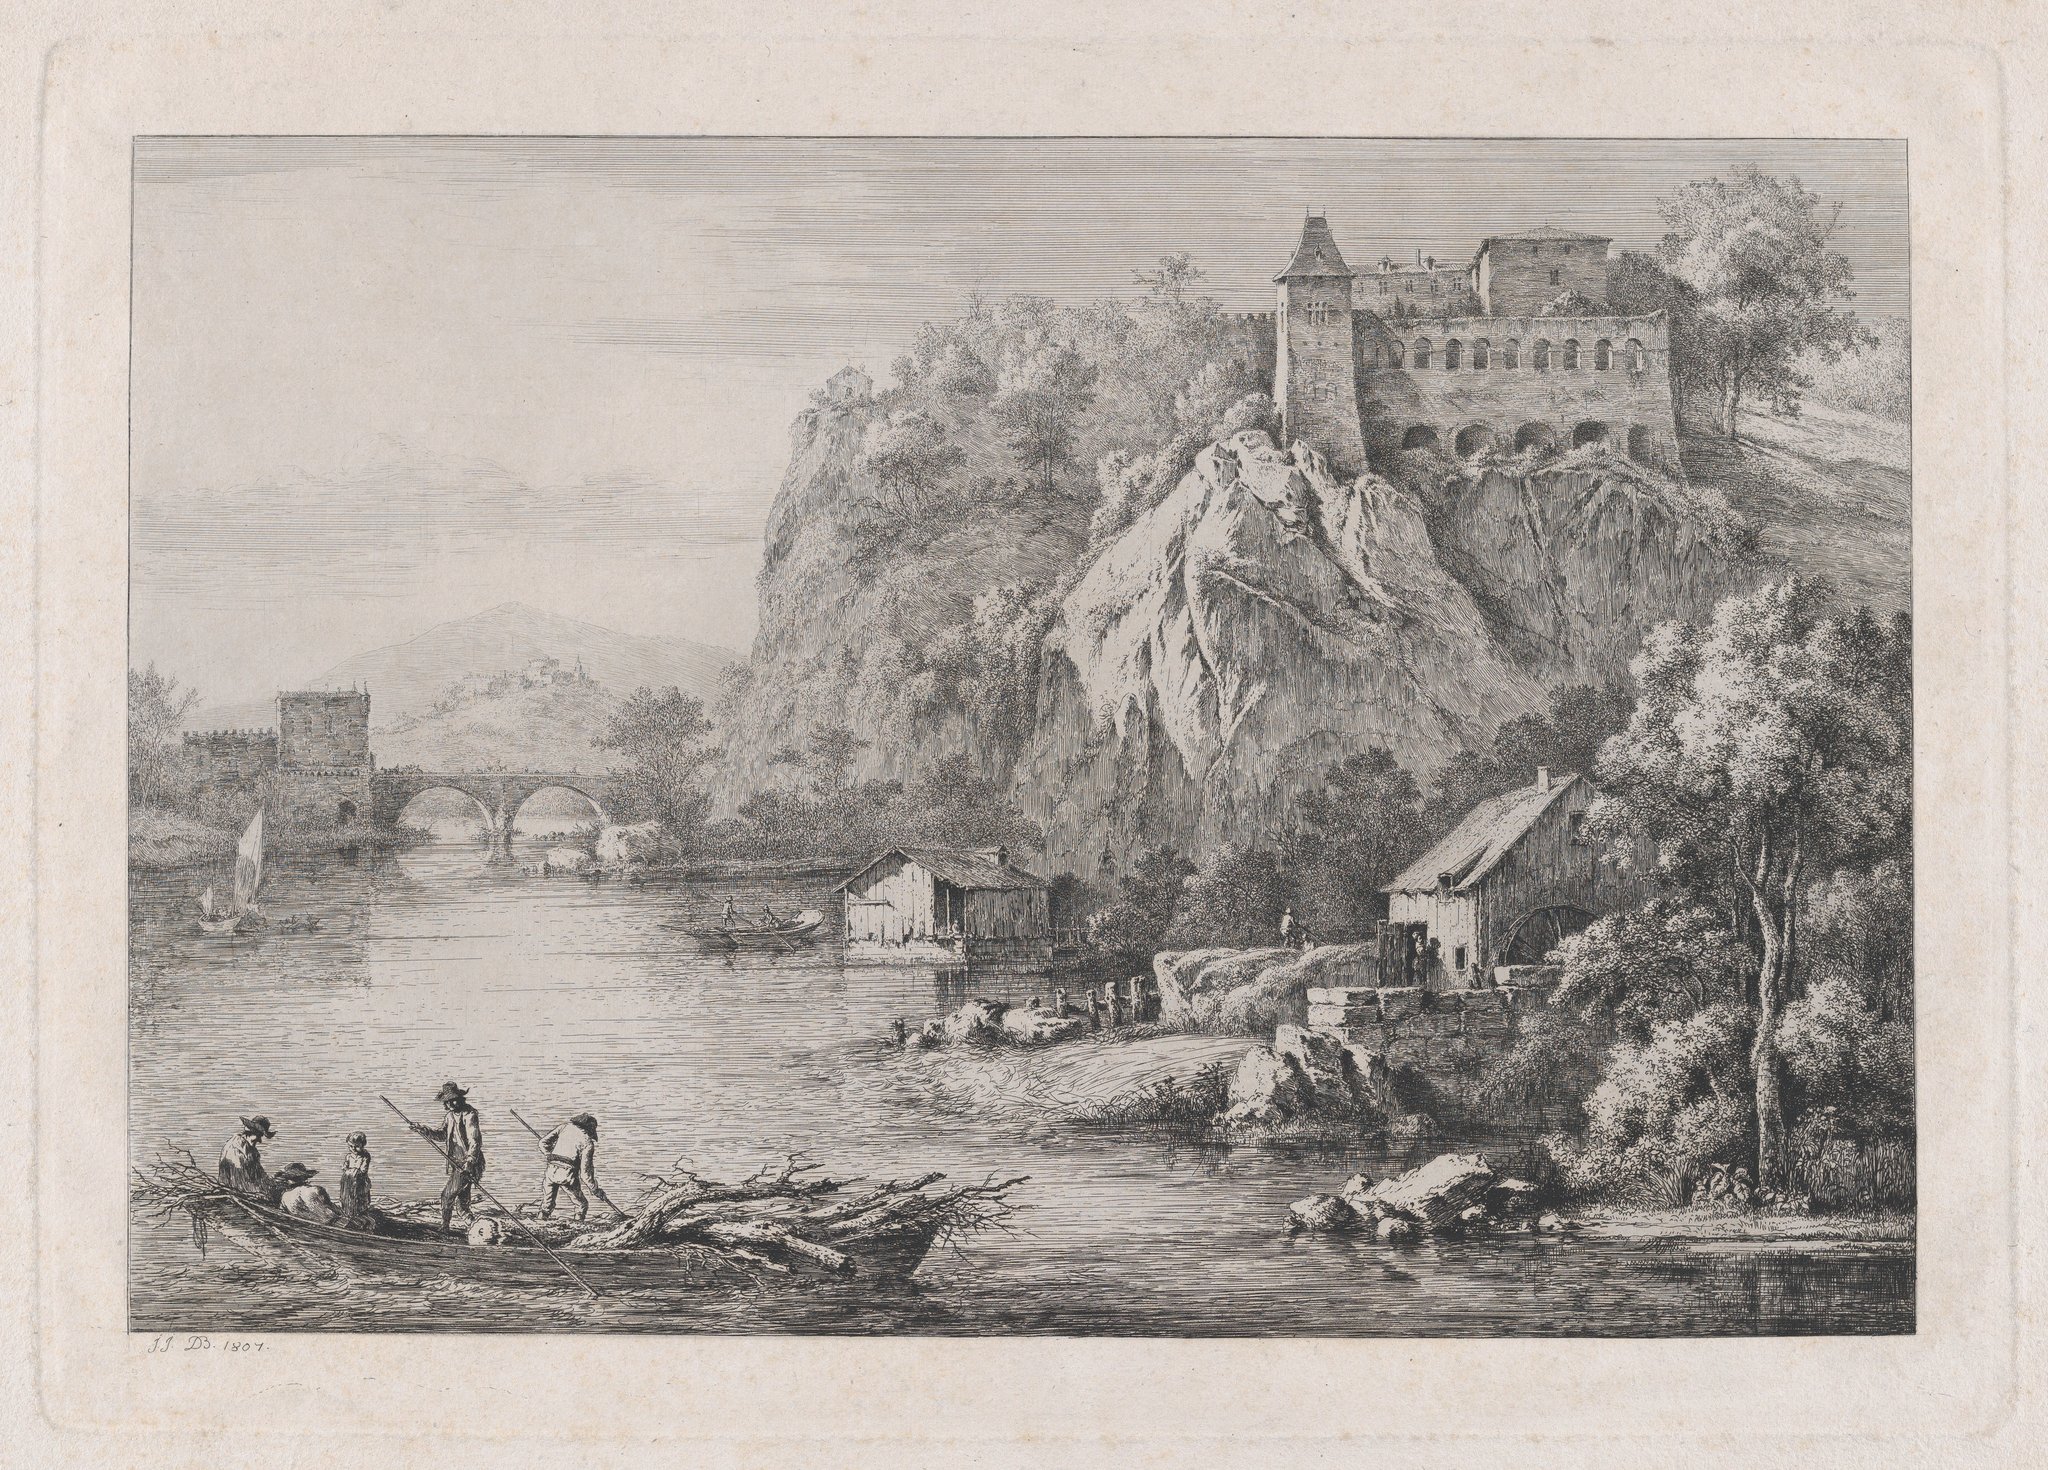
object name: print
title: View of the Convent of the Barefooted Carmelites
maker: jean jacques de boissieu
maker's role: artist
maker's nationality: french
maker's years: 1736-1810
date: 1807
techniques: drypoint, etching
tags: men,rivers,boats